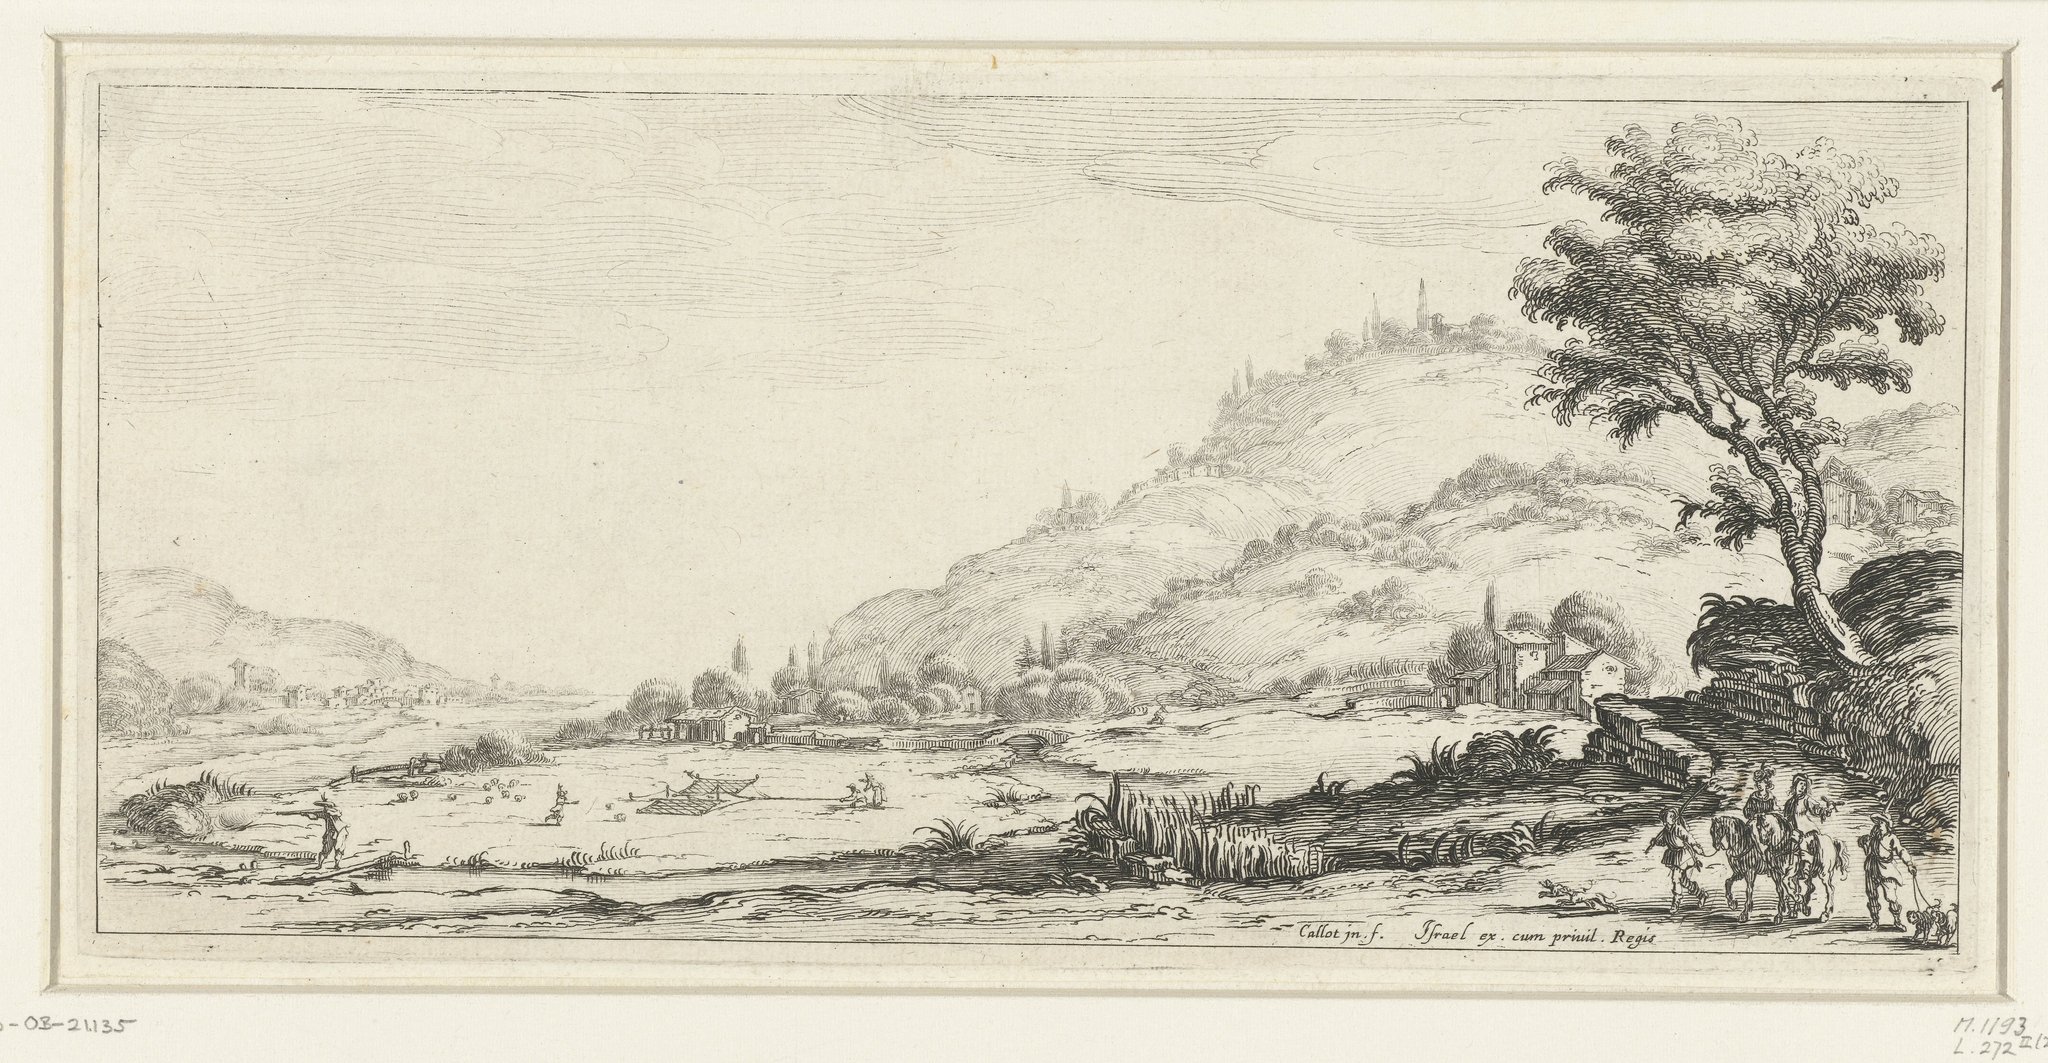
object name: print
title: Vogeljacht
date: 1628-1635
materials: paper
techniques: etching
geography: paris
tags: city-view, and landscape with man-made constructions, hunting, chase, sports, games ~ animals (+ hunting with falcon, hawk; falconry), mountains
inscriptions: collector's mark: Lugt 240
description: Bergachtig landschap met rechts op de voorgrond een groepje valkeniers. Links een jager die op eenden schiet. Op de achtergrond mannen die vogels vangen met twee grote netten. Deze prent is onderdeel van een serie van 11 Italiaanse (waarschijnlijk voornamelijk Florentijnse) landschappen (12 incl. titelprent).